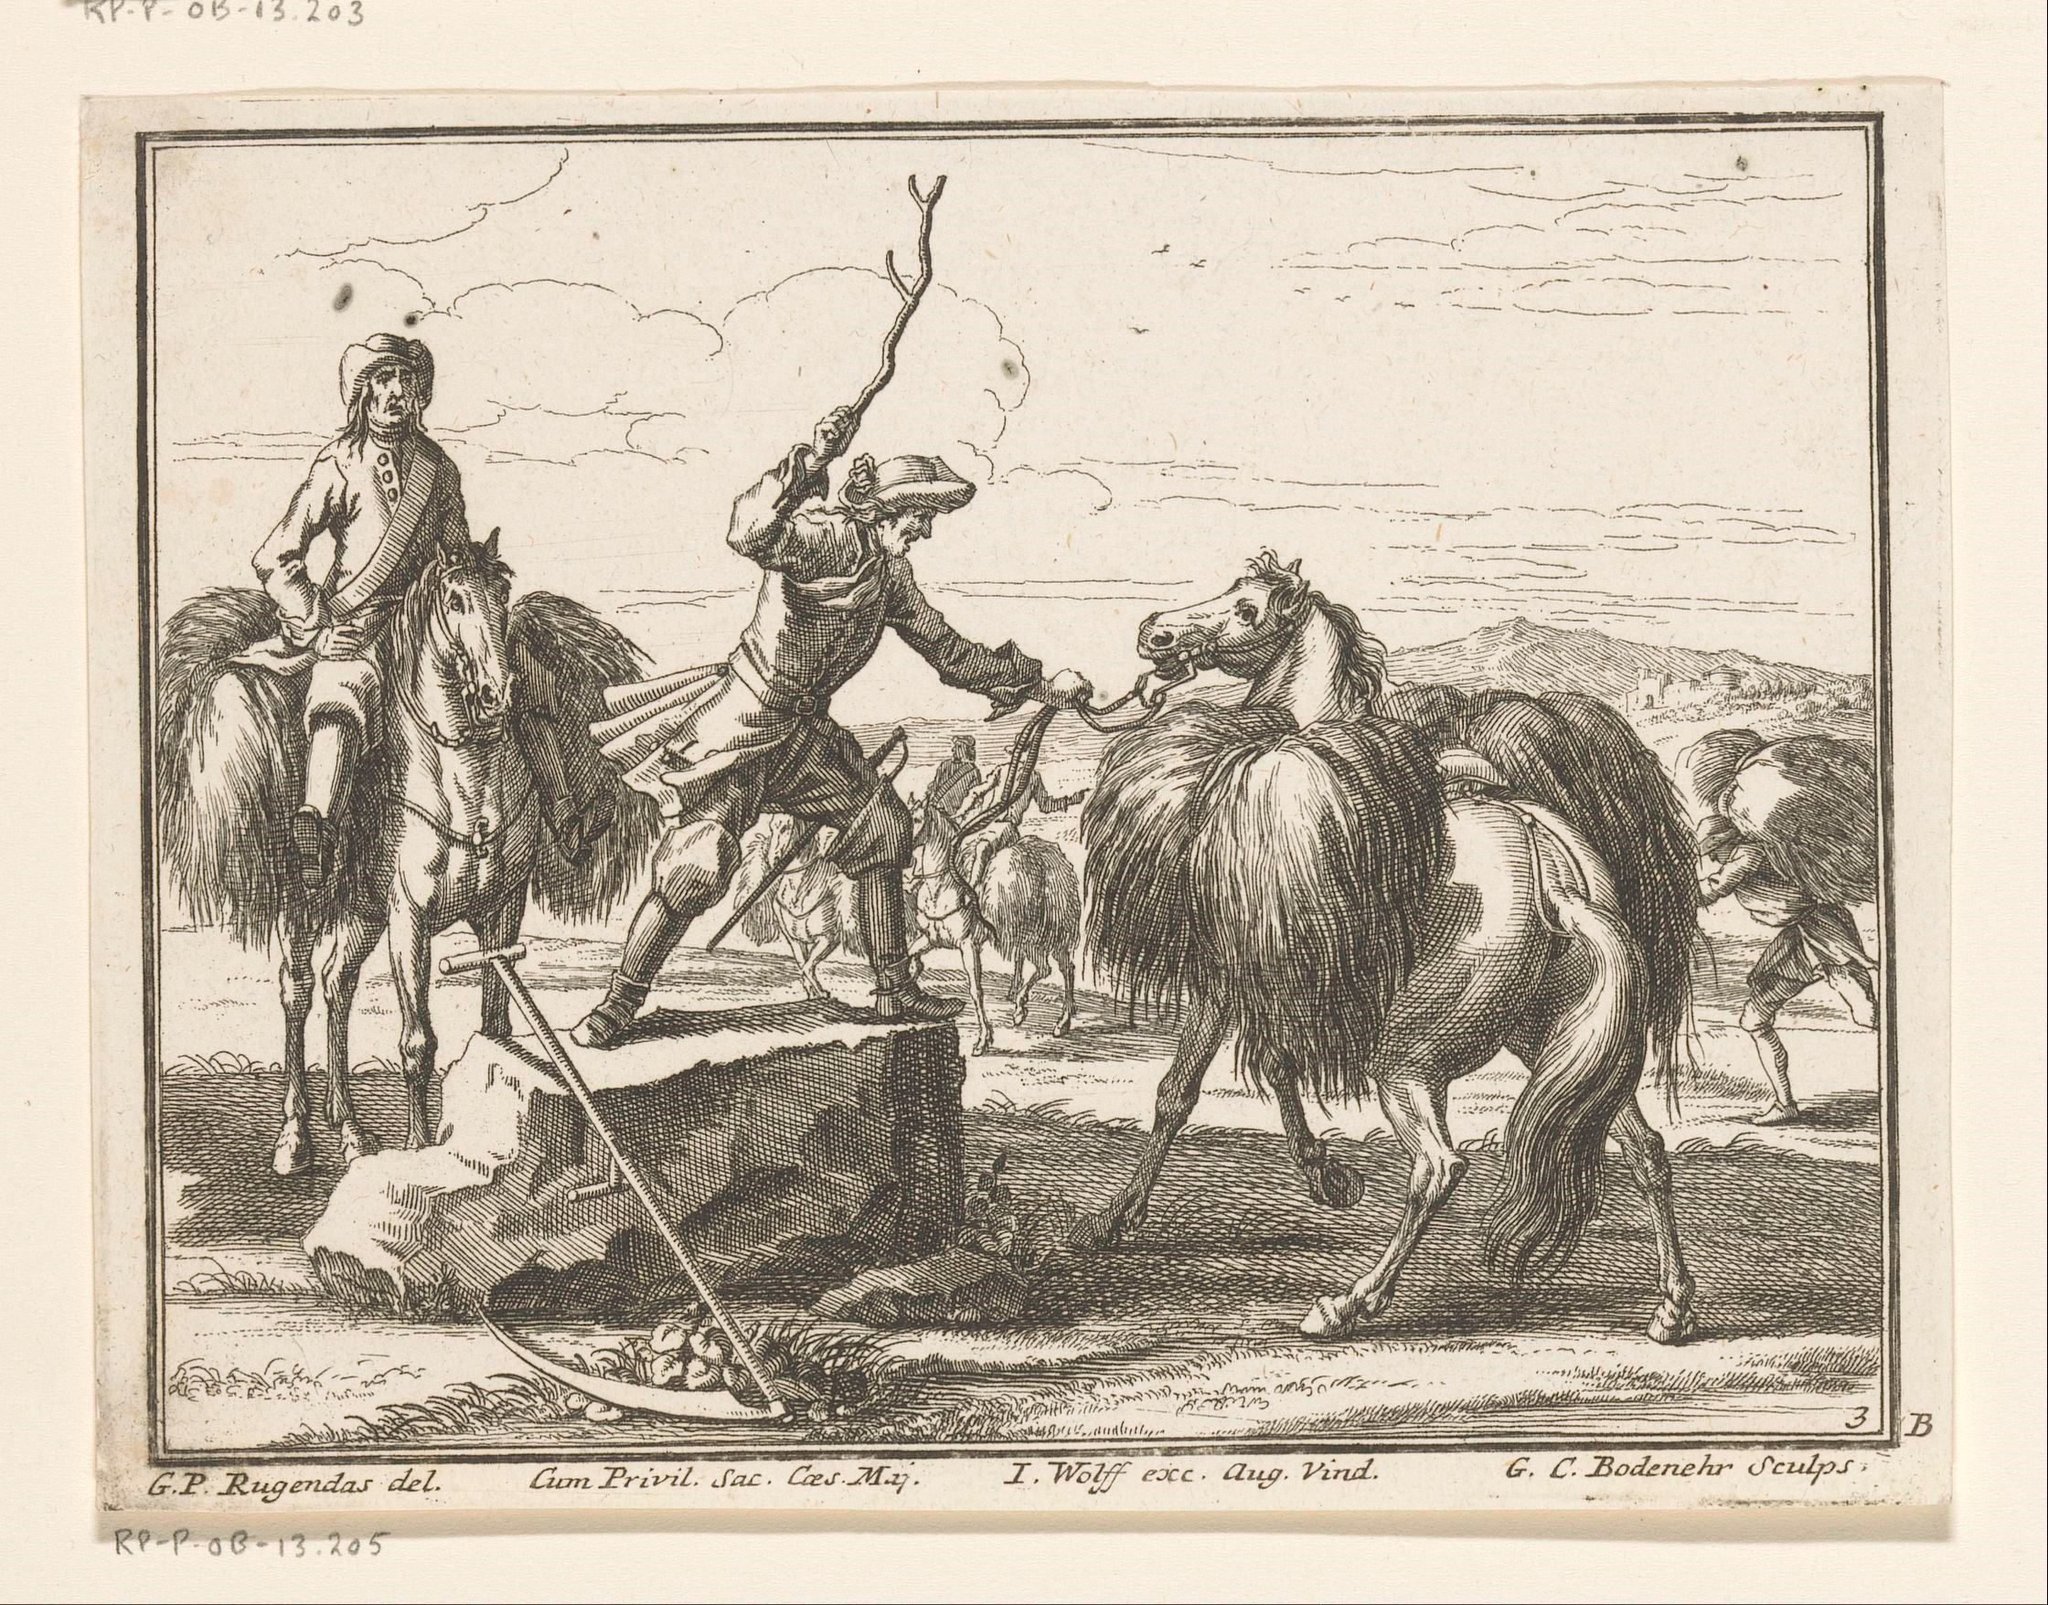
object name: print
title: Paarden beladen met hooi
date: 1686-1710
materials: paper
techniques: etching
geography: augsburg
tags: agricultural implements: scythe, private soldier (+ cavalry, horsemen), agricultural products and by-products: hay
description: Onderdeel van in totaal 37 prenten door Georg Conrad Bodenehr naar Georg Philip Rugendas I. Deze prent maakt onderdeel uit van serie 'B', bestaand uit acht prenten met ruiters.